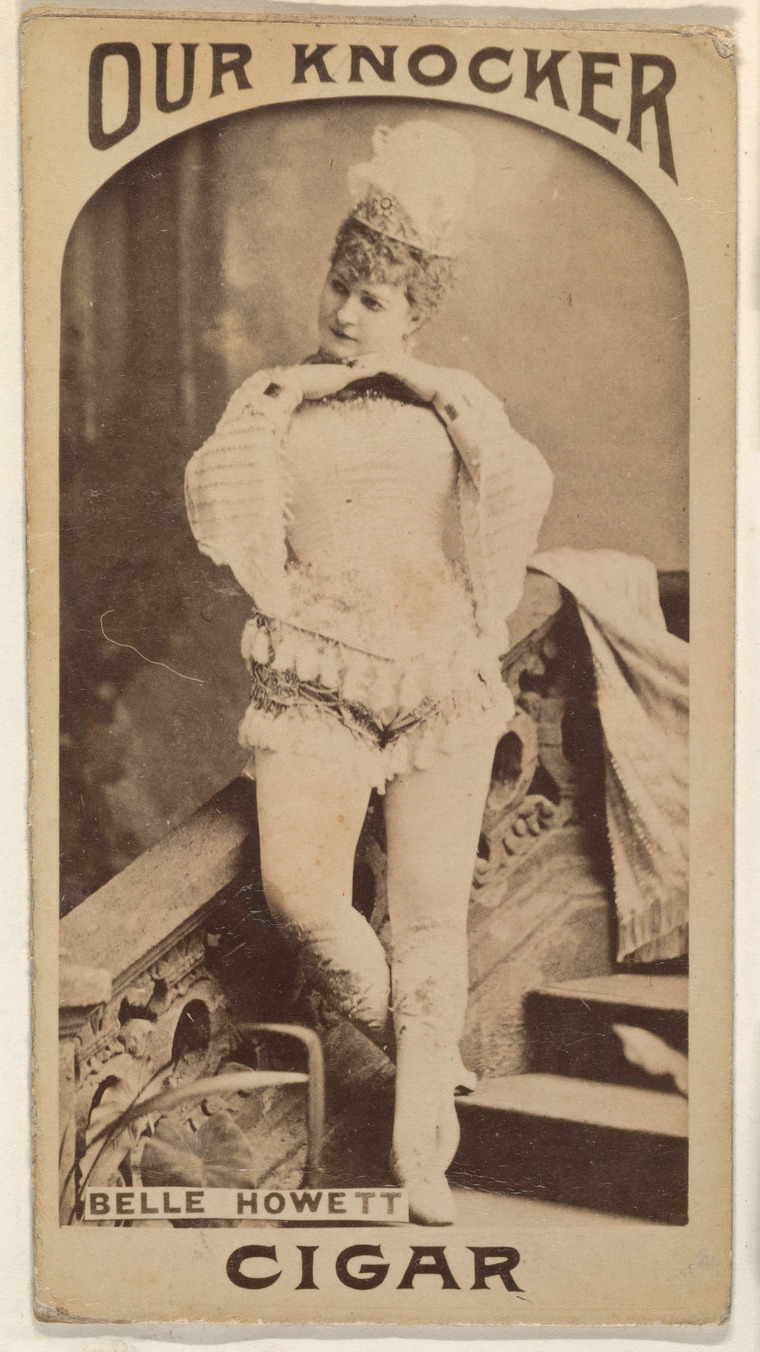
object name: photograph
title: Belle Howett, from the Actresses series (N665) promoting Our Knocker Cigars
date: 1888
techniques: albumen silver print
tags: portraits,women,actresses